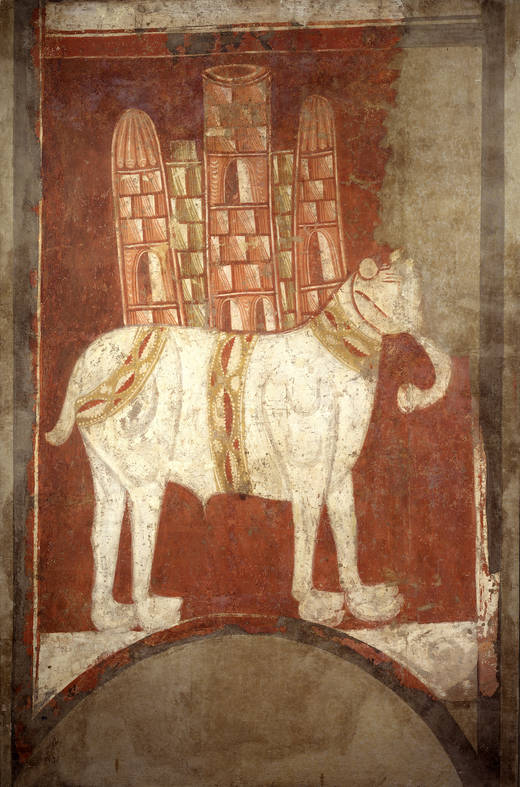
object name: fresco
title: Elephant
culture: spanish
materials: canvas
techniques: fresco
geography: spain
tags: castles,elephants